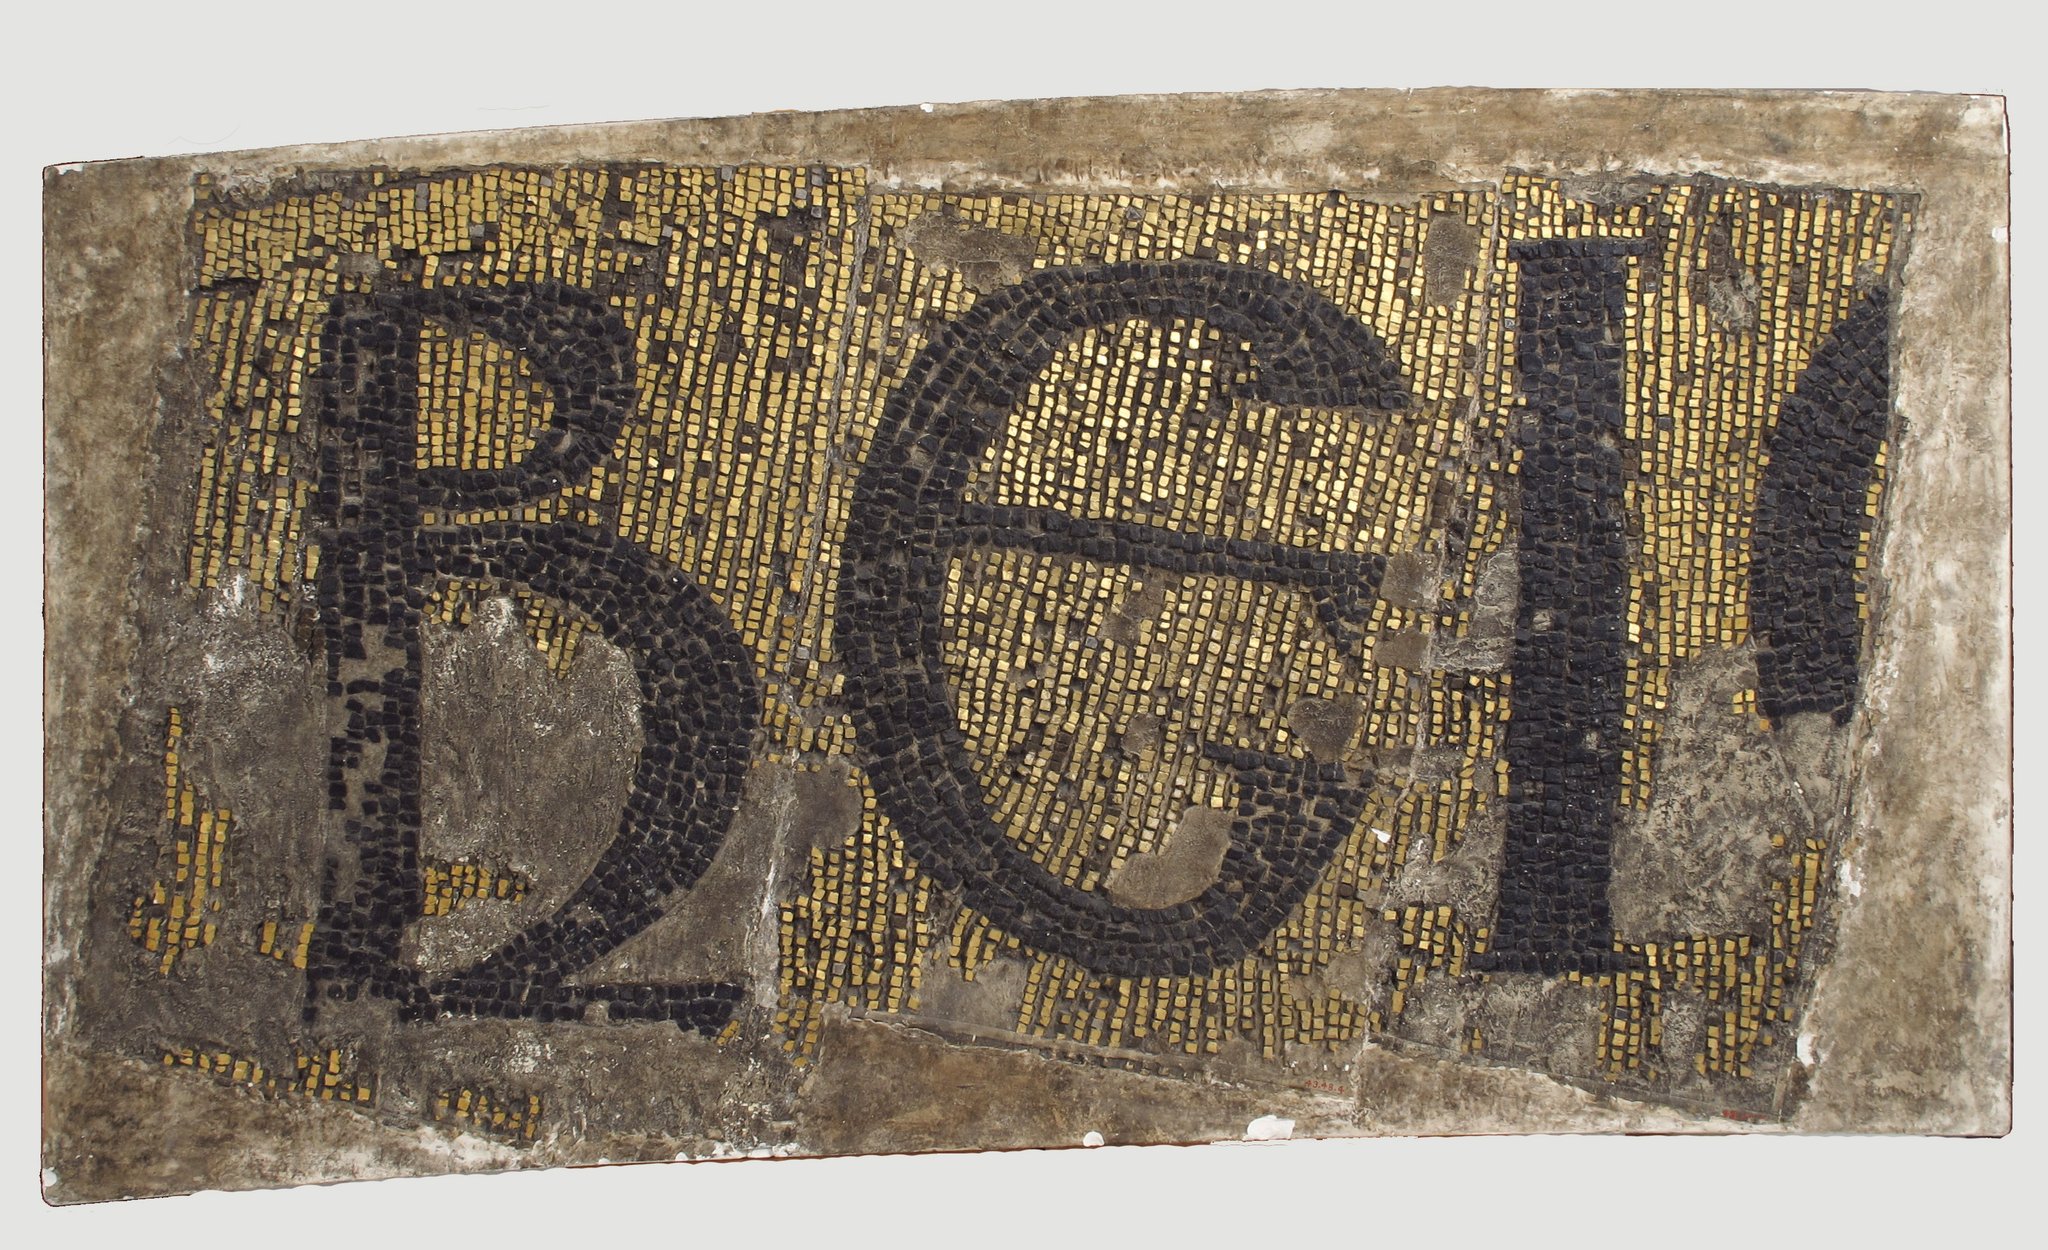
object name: mosaic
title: Letters from an Inscription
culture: byzantine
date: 1901-1933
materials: plaster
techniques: casting, painting